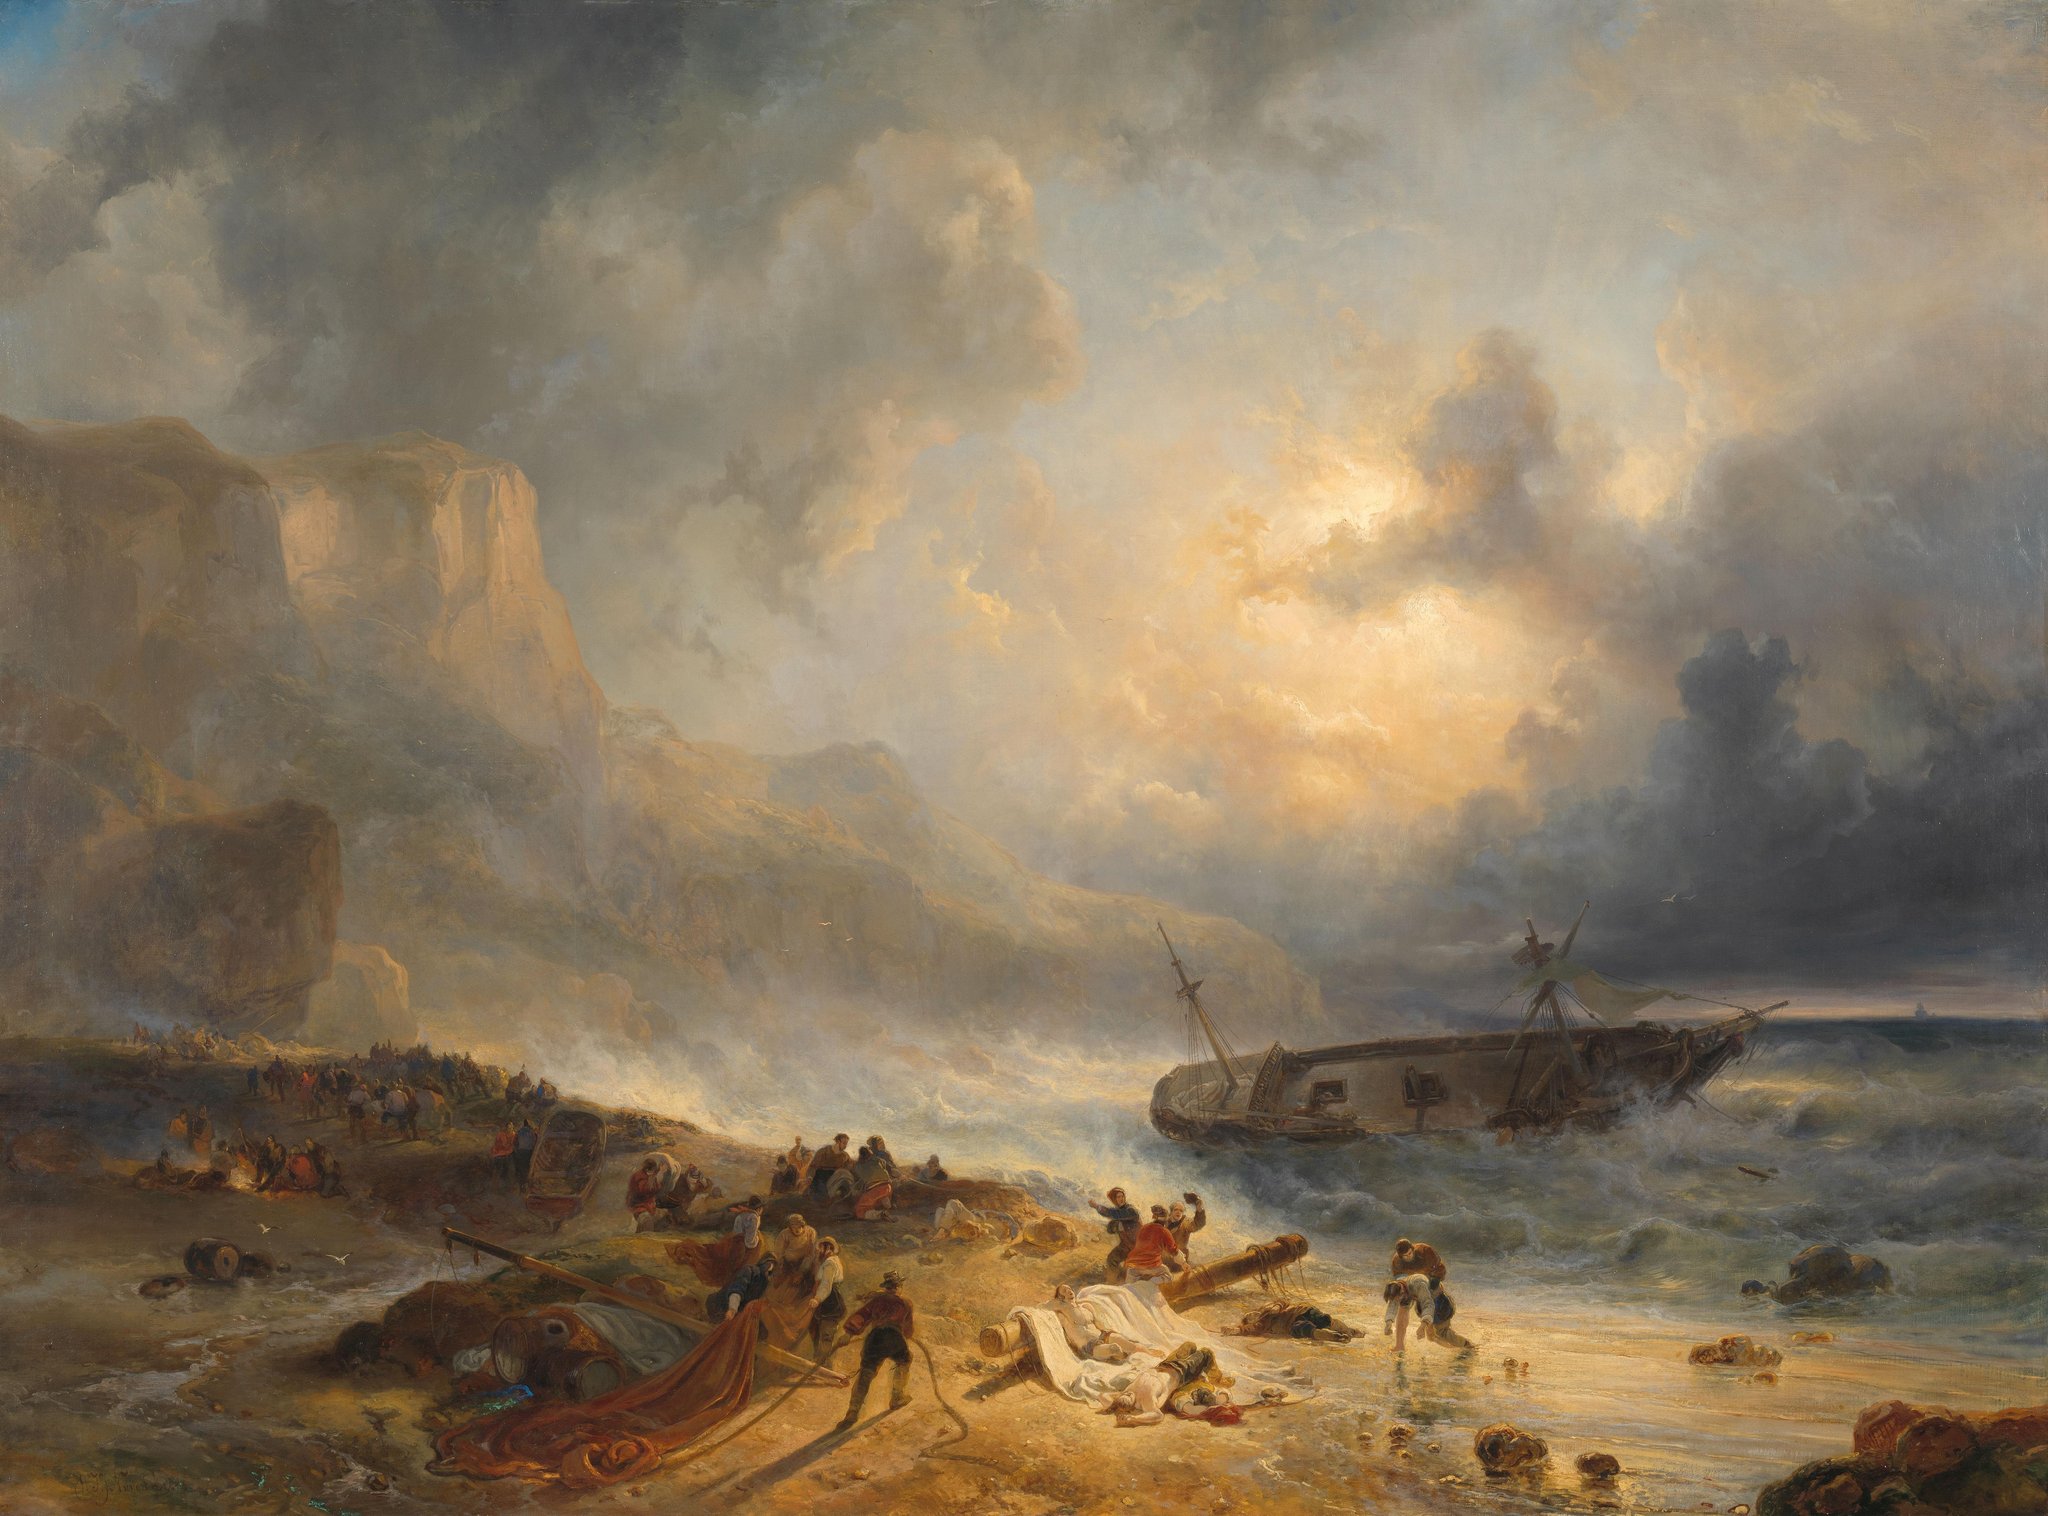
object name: painting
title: Shipwreck off a Rocky Coast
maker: wijnand nuijen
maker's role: draughtsman, painter, print maker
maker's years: 1813-1839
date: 1837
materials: canvas, oil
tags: drowning, shipwrecked person, rocky coast, shipwreck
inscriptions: signature: ‘W.J.J. Nuijen Bz. f.’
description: This painting is a highlight of Dutch Romanticism. It represents the insignificance of man in the face of nature. During a storm, a three-master has struck a rock and foundered. The crew desperately combs the beach in search of survivors. Rays of sun pierce through the gloomy sky and afford a view of the overwhelming sheer cliffs, which make the people seem even smaller.